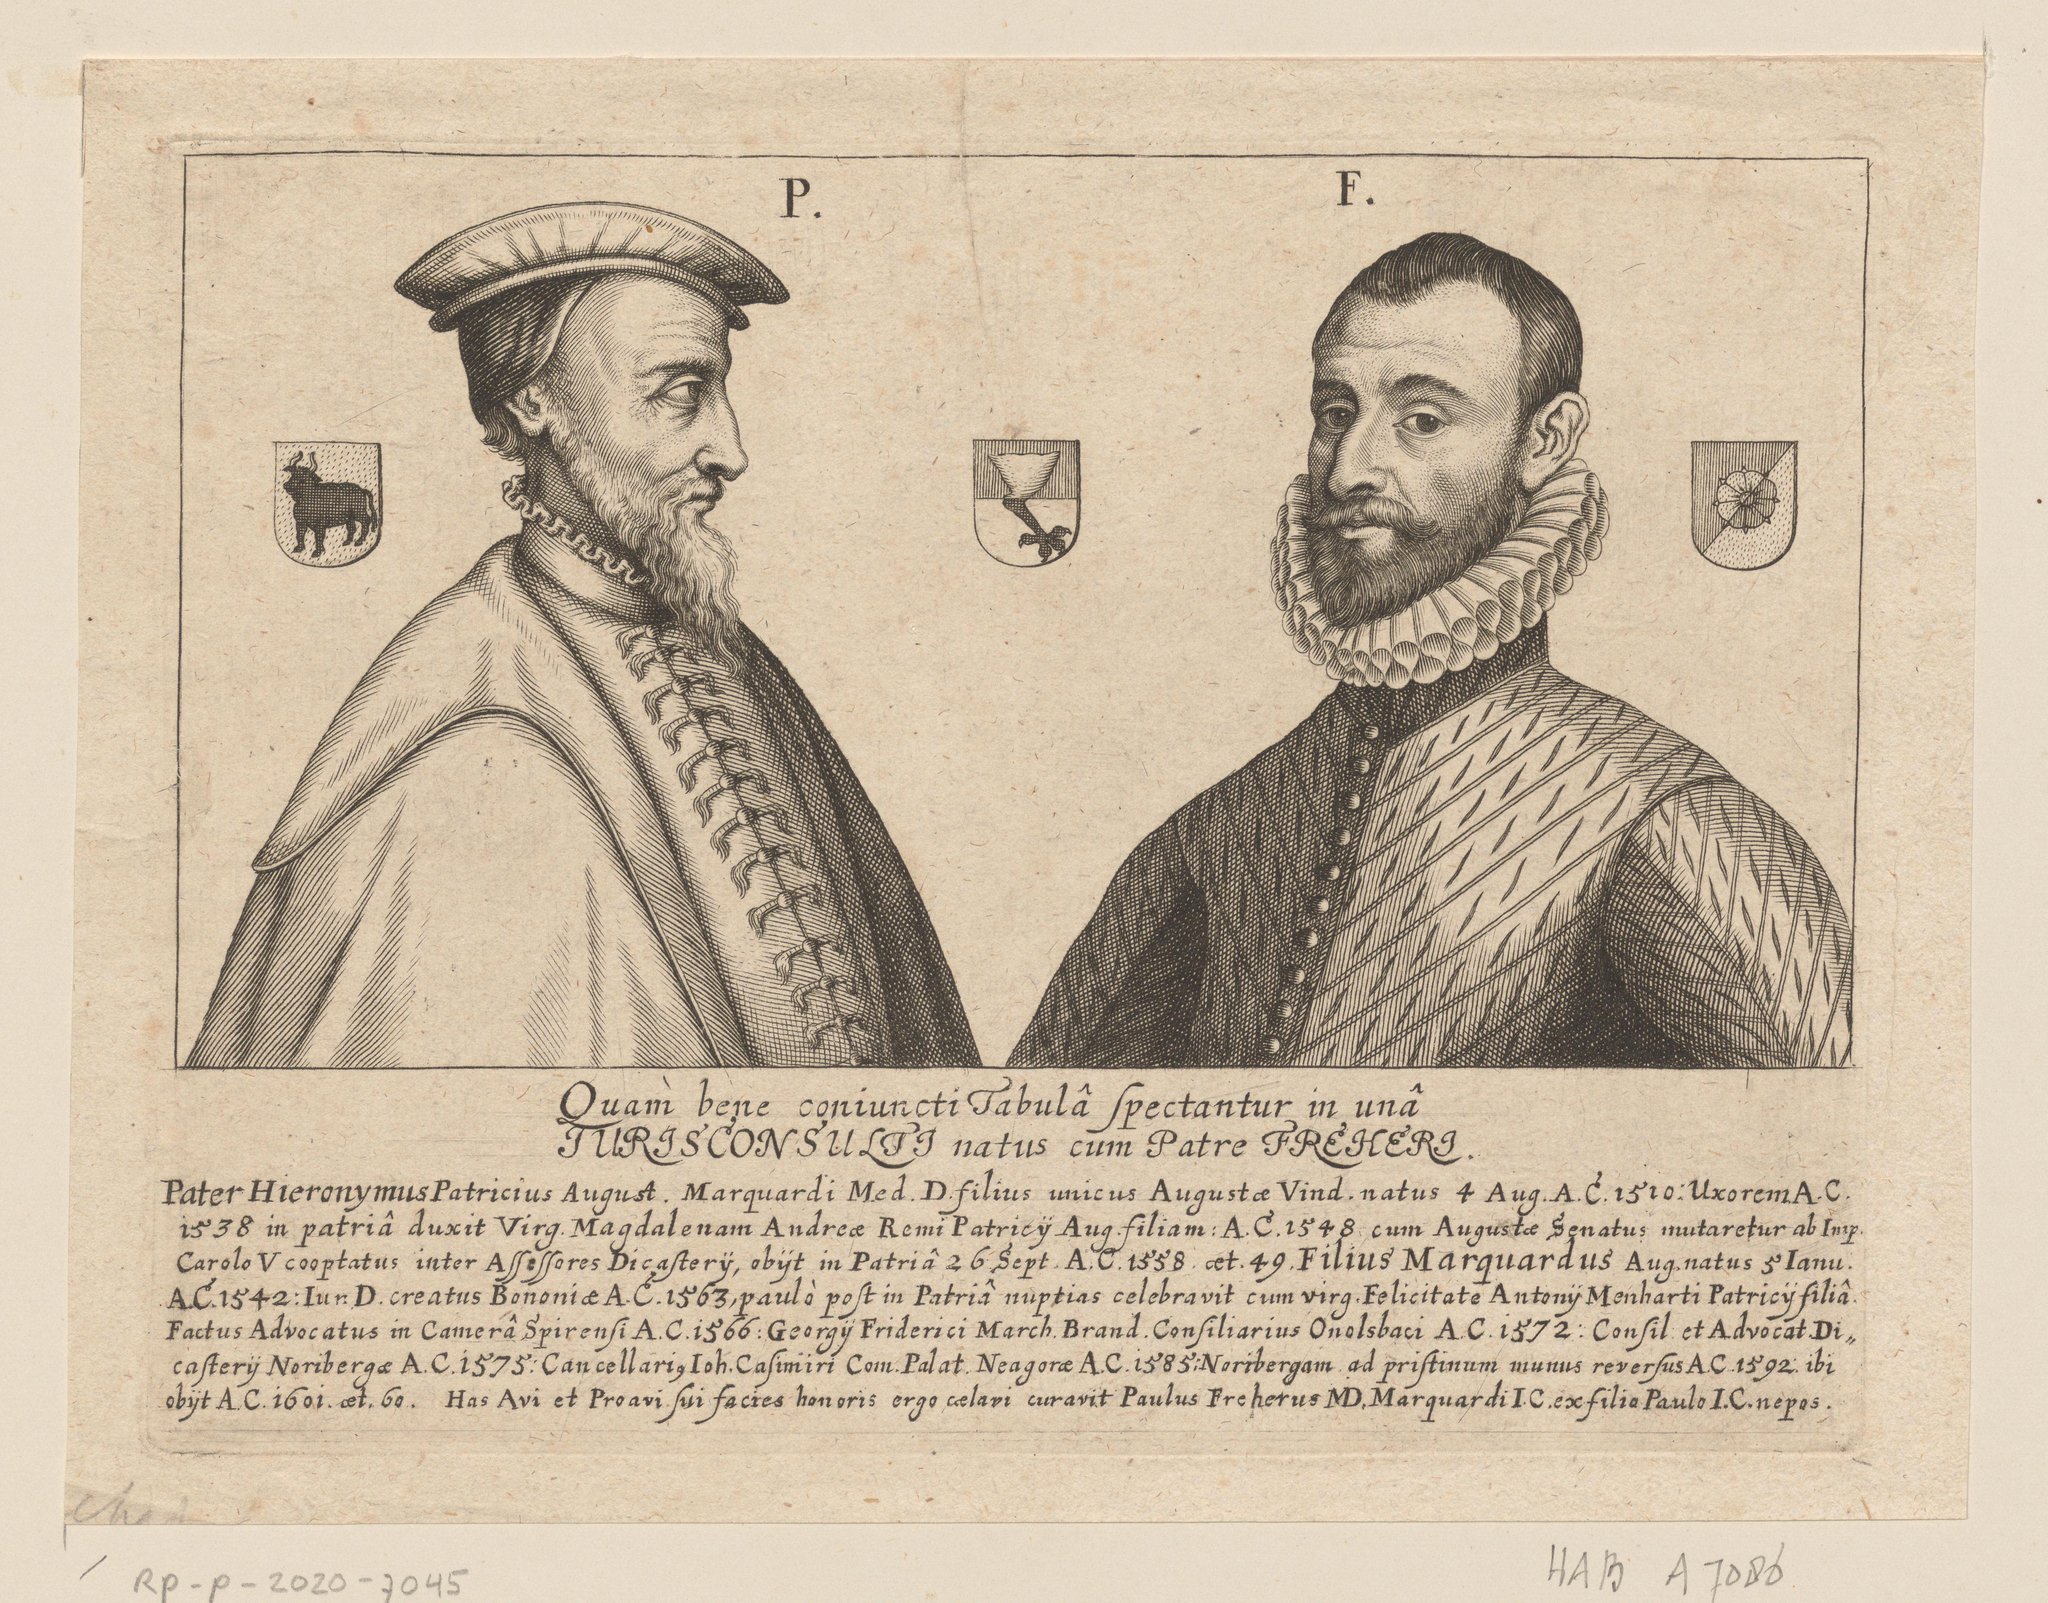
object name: print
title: Dubbelportret van Hieronymus en Marquard Freher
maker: Anonymous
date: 1601-1650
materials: paper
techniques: engraving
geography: germany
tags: historical person in a double portrait, father and son(s) (family group), armorial bearing, heraldry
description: Met onderschrift in het Latijn. Boven Hieronymus gemerkt: P. Boven Marquard gemerkt: F.